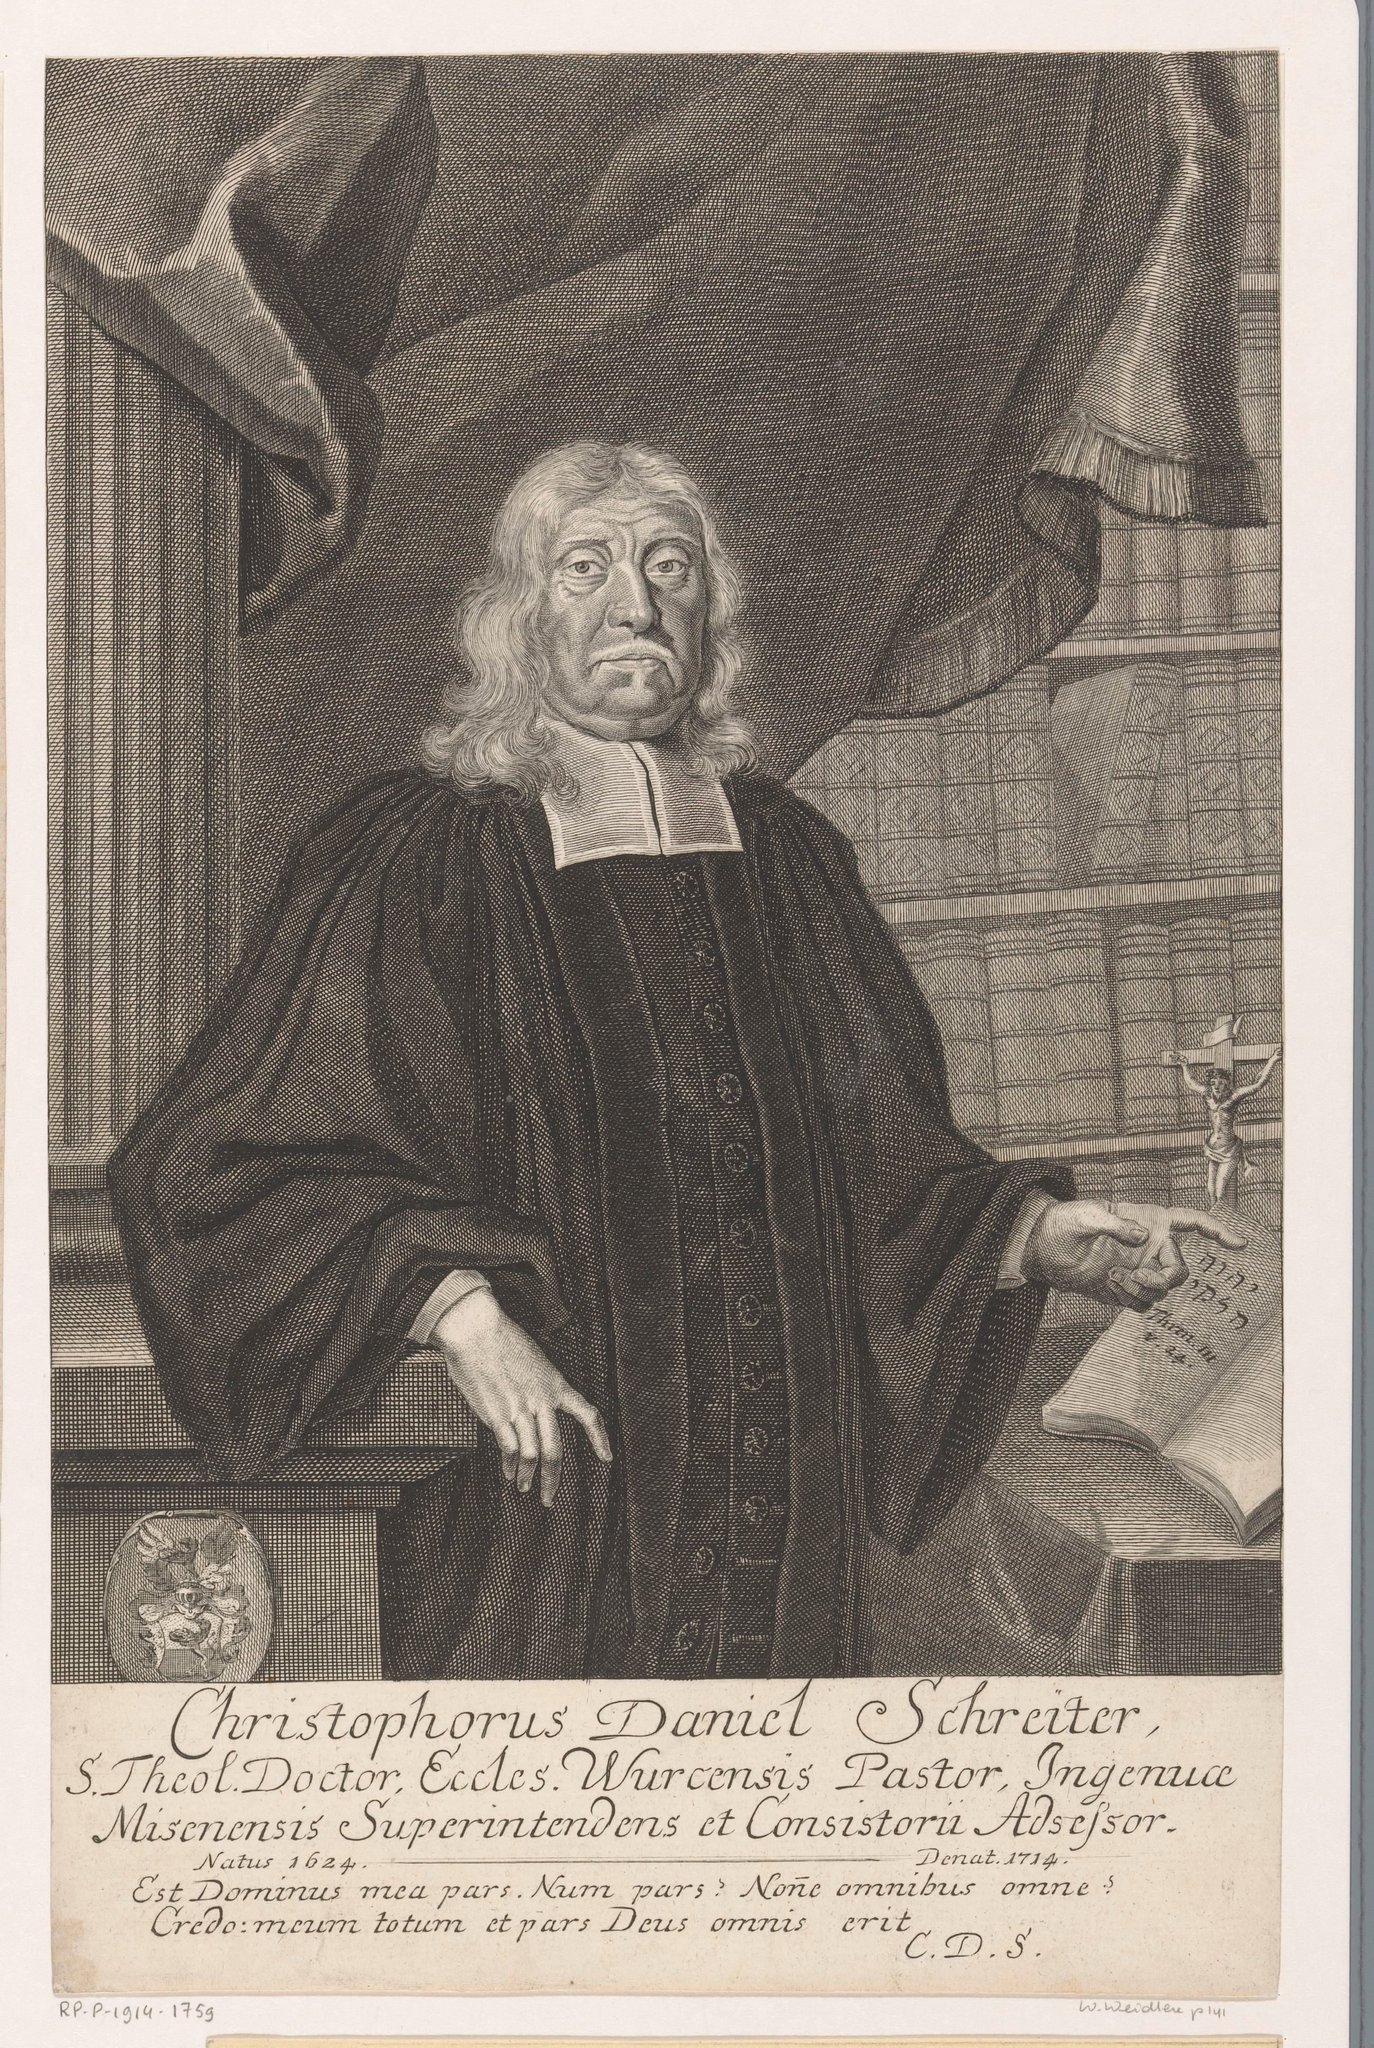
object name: print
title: Portret van Christoph Daniel Schreiter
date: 1714-1733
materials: paper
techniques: engraving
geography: leipzig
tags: bookshelves, historical persons, book - mm - book open, crucifix ~ personal devotion, armorial bearing, heraldry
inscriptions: collector's mark: Lugt 2228